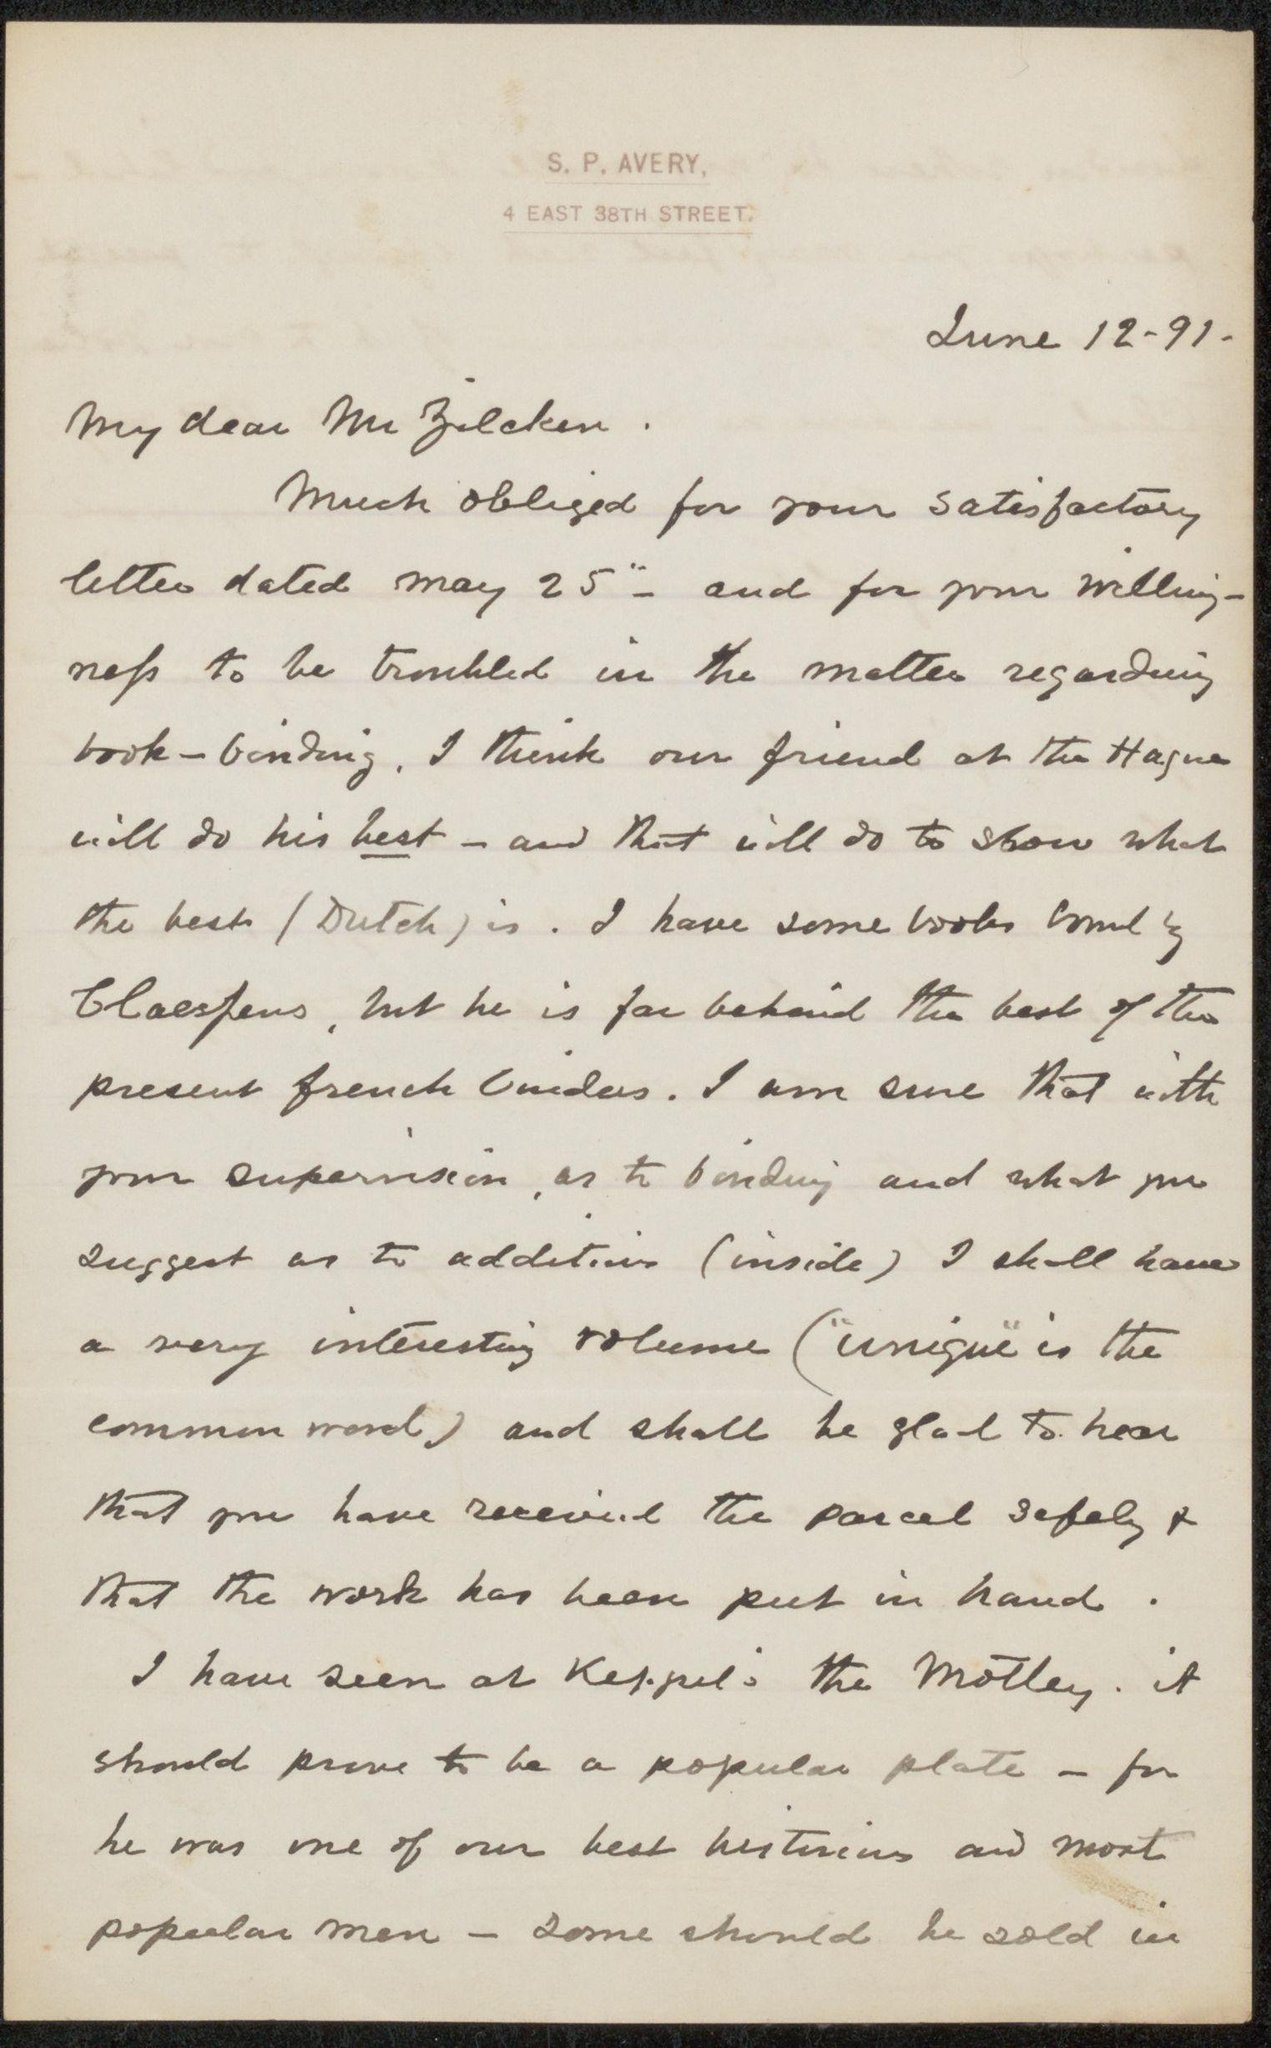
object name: letter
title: Brief aan Philip Zilcken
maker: samuel putnam avery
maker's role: verzamelaar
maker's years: 1822-1904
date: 1891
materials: ink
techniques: pen, printing, writing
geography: new york city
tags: the hague, painter, draughtsman, philip zilcken, printed matter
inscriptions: collector's mark: ‘RPK’